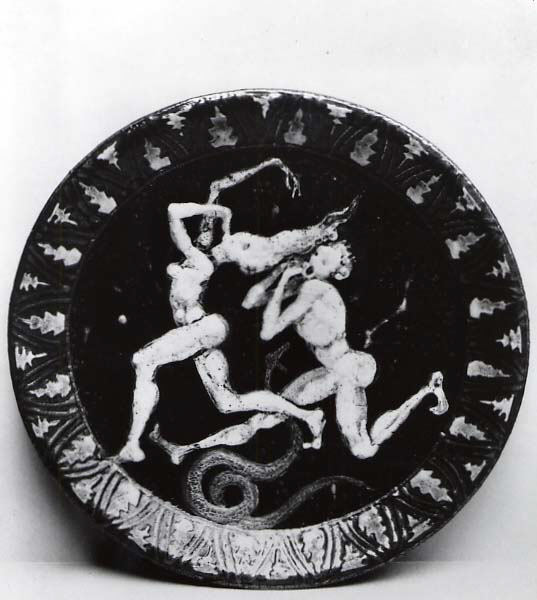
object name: plate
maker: andré metthey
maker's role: designer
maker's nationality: french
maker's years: 1871-1920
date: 1912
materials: earthenware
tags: adam,eve